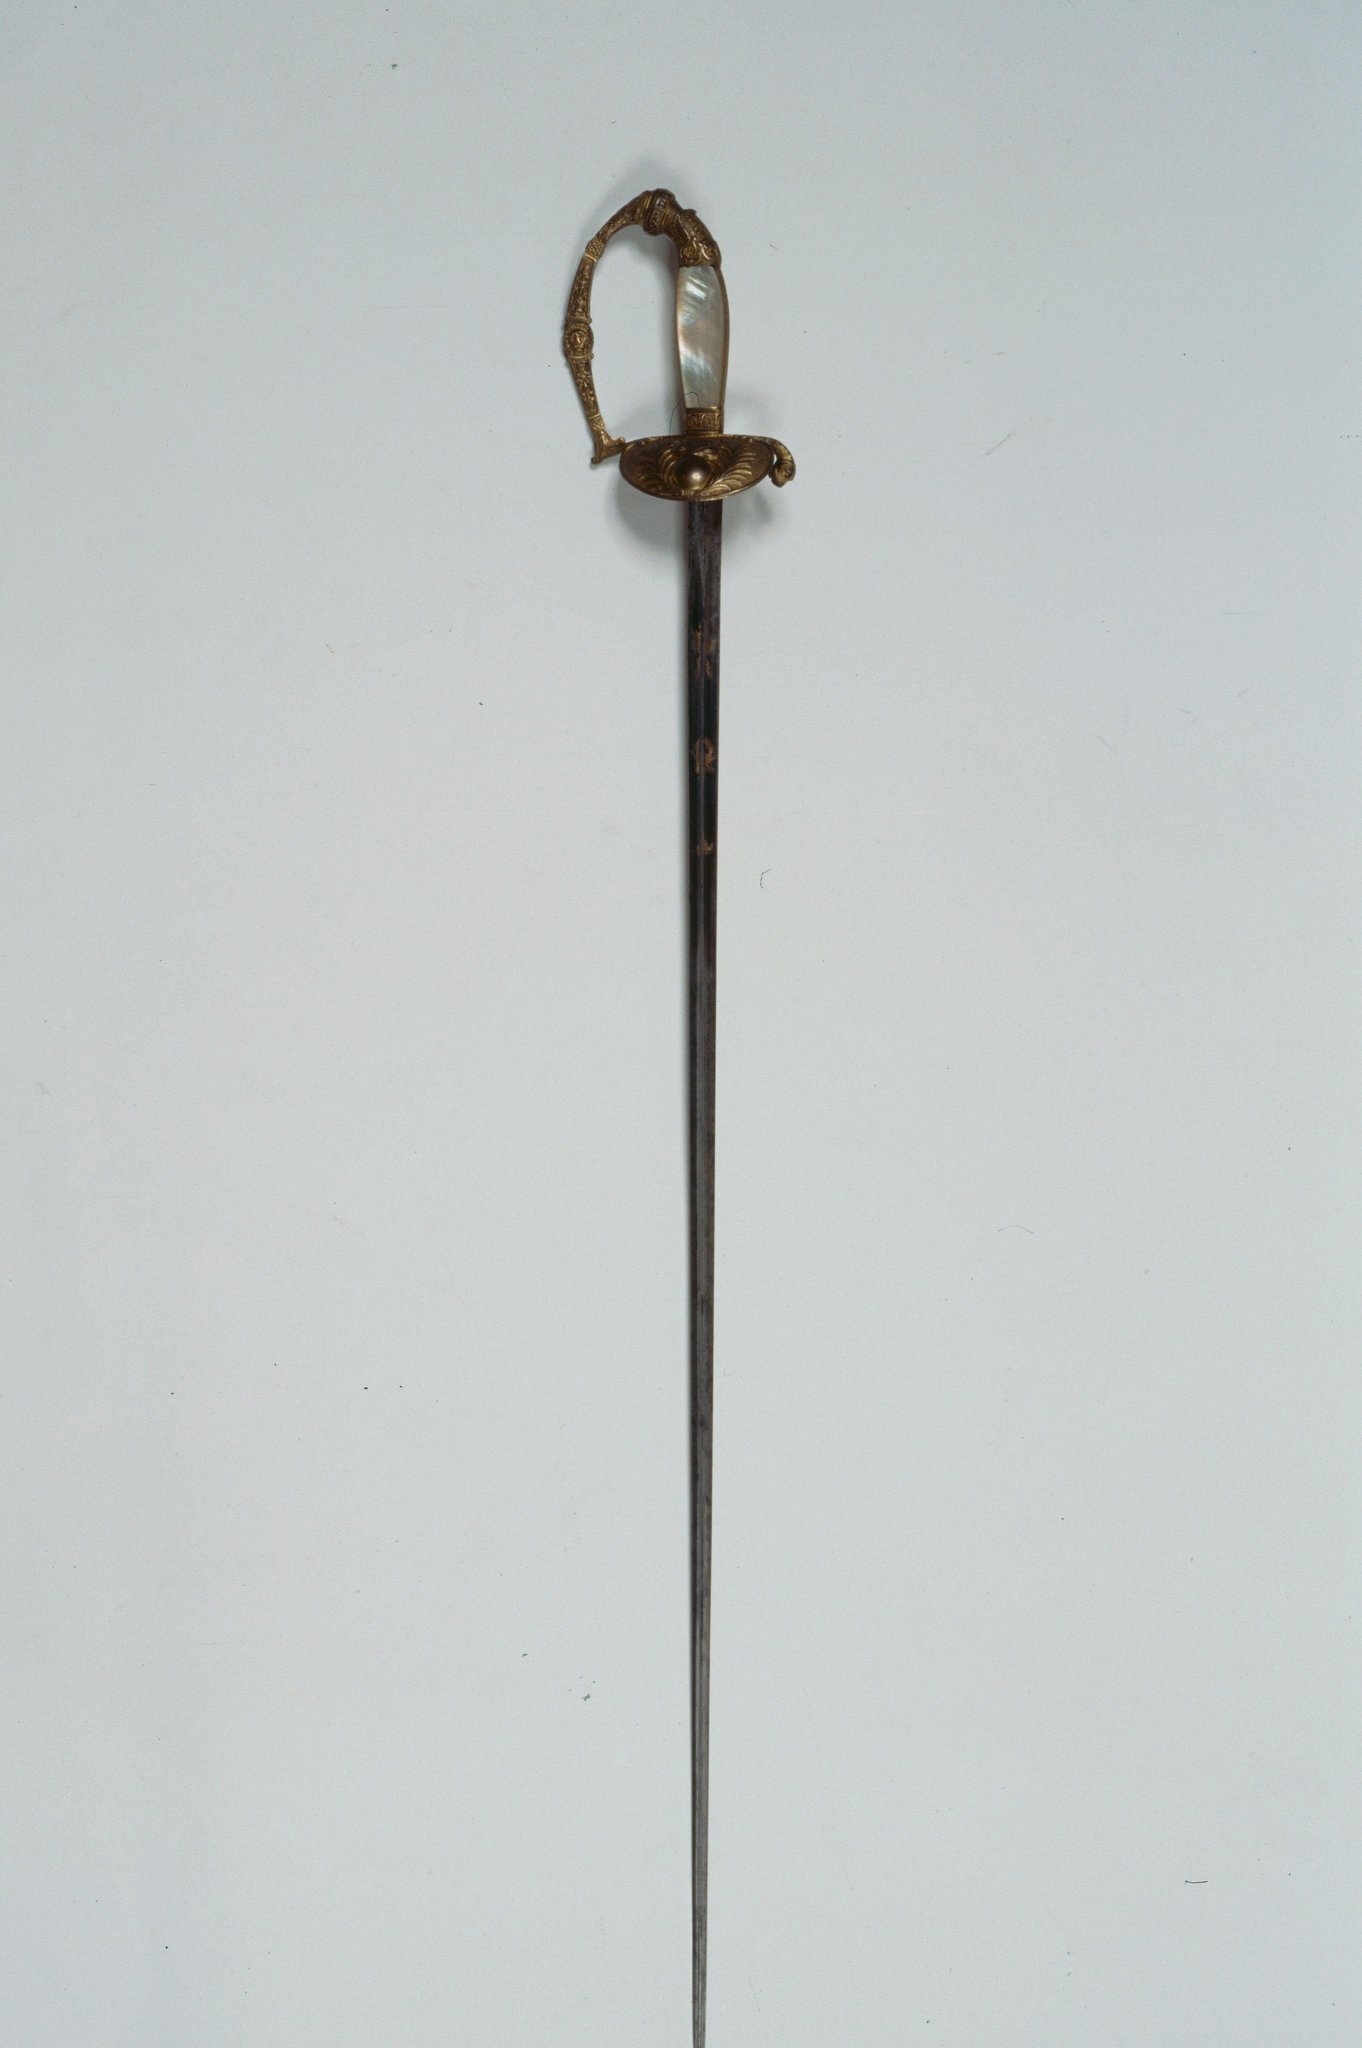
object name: sword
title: Degen van H. de Vos van Steenwijk (cadet kurassiers nr. 3)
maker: s. de jager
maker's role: zwaardveger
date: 1815-1830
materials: brass, iron, leather, mother of pearl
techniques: engraving, gilding, inlay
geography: haarlem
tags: netherlands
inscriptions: mark: ‘I.V.E S. DE JAGER’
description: Degen voor officieren karabiniers of kurassiers, 1815-1830. De kling is driekantig en het gevest van gegoten messing. Parelmoer op de greep, op de stootplaat een springende granaat. Onder de stootplaat 'S. de Jager' en de letters 'I.V.E.'. Met graveerwerk, enigszins geblauwd en verguld. Met zwart leren schede. Monding van messing en oorband met haak. Gedragen door H. baron de Vos van Steenwijk als cadet bij de 3e Afdeling Kurassiers.